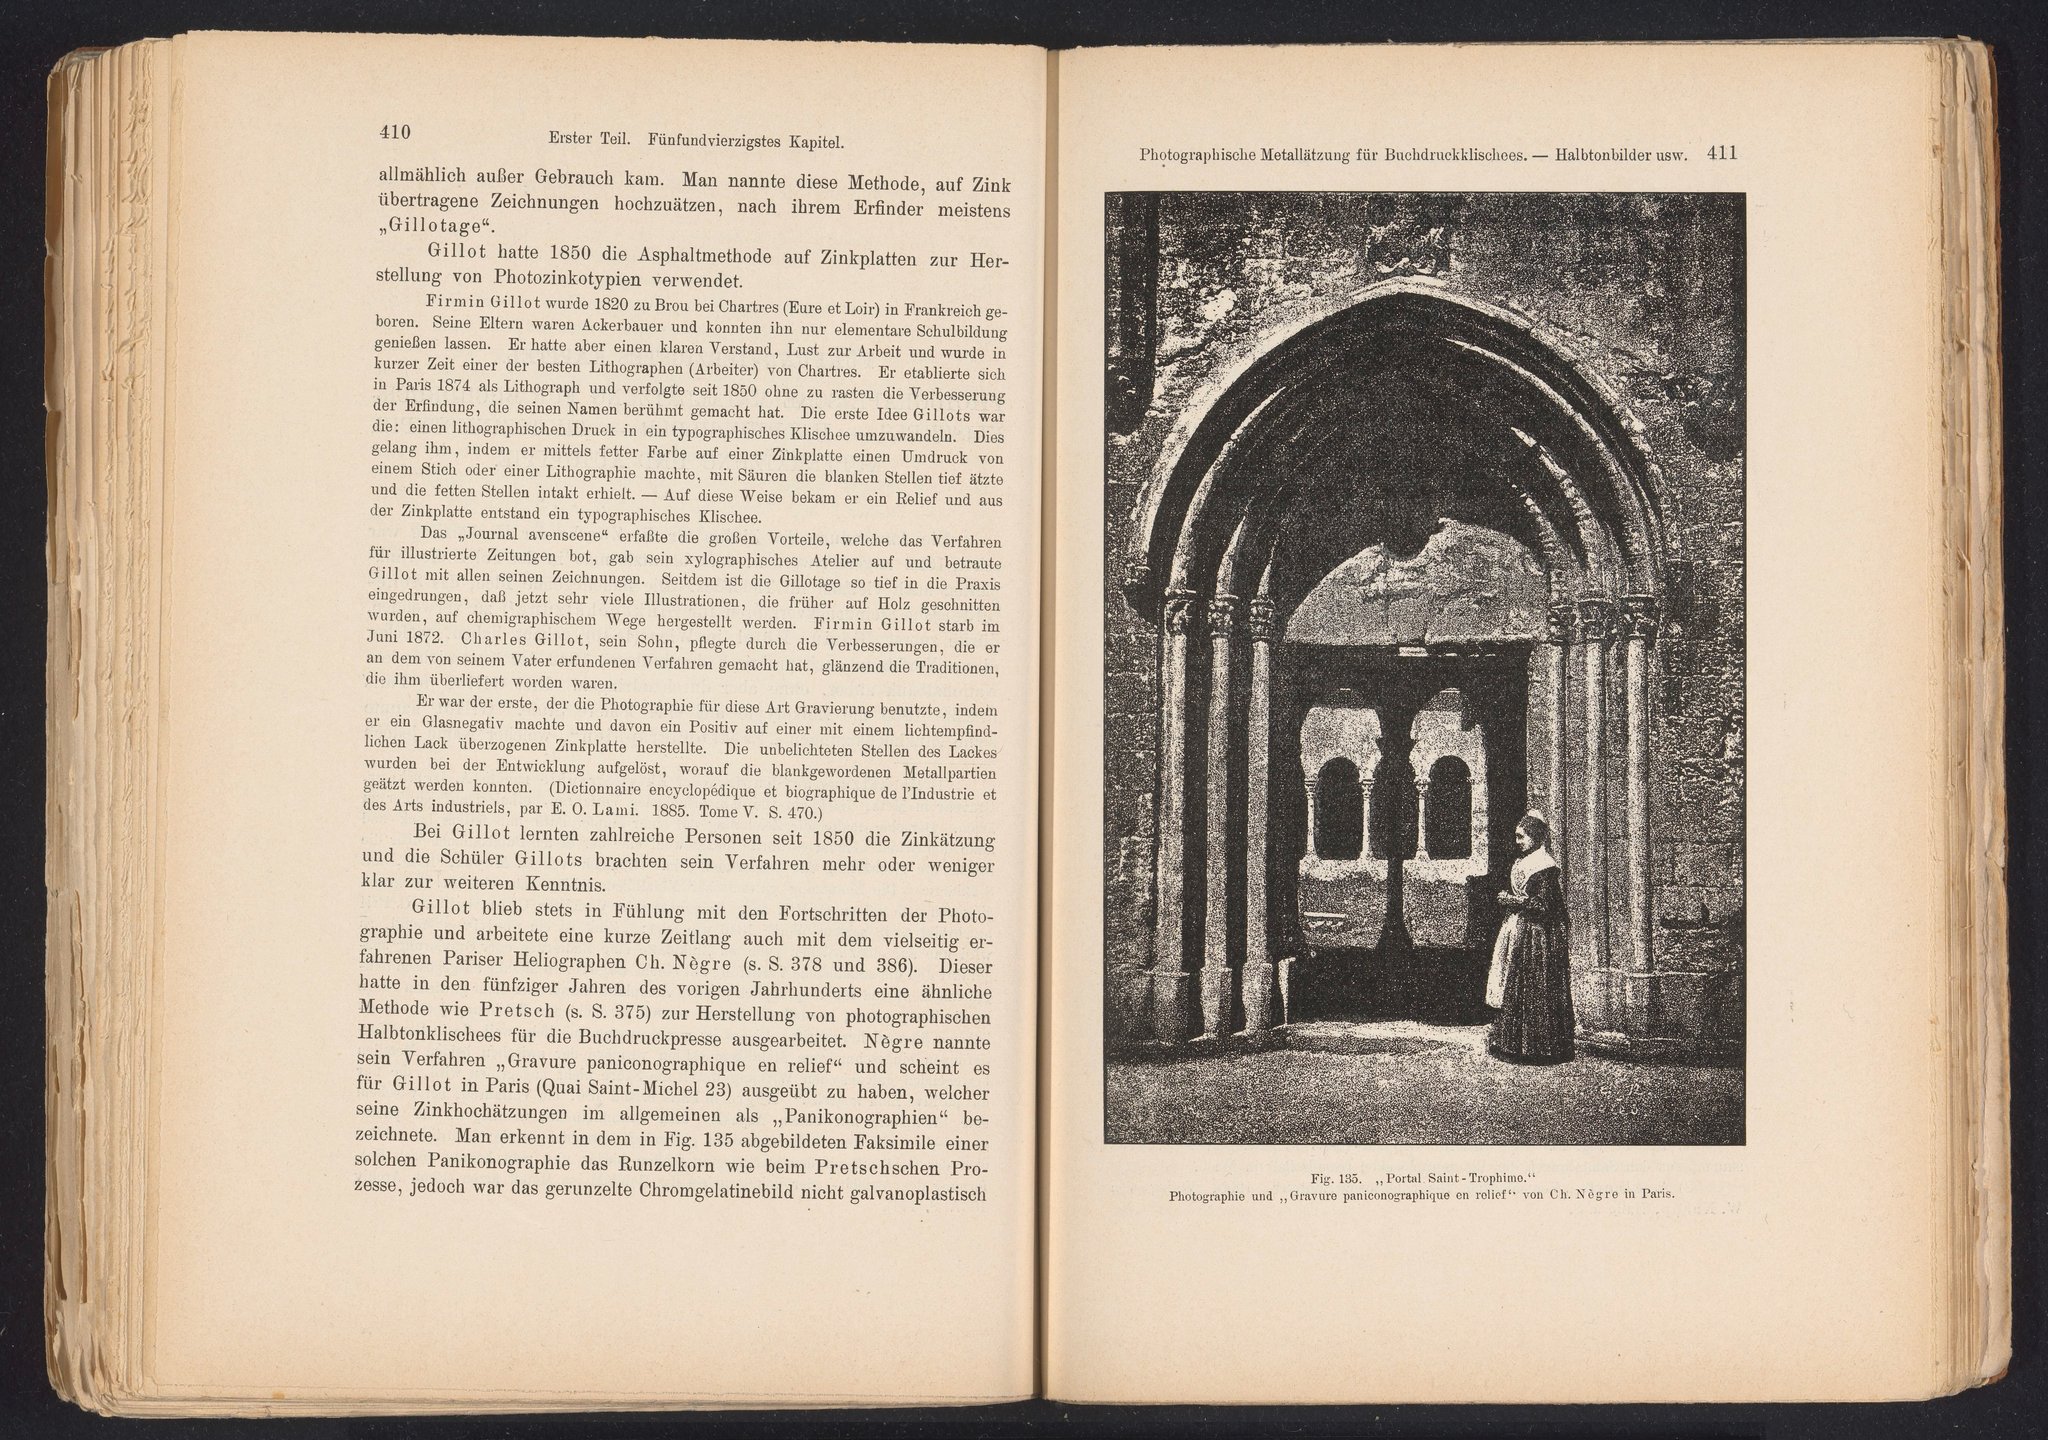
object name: page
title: Portal Saint-Trophime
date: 1900-1905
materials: paper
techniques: autotype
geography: arles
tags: parts of church exterior and annexes: portal, adult woman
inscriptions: number: ‘Fig. 135.’